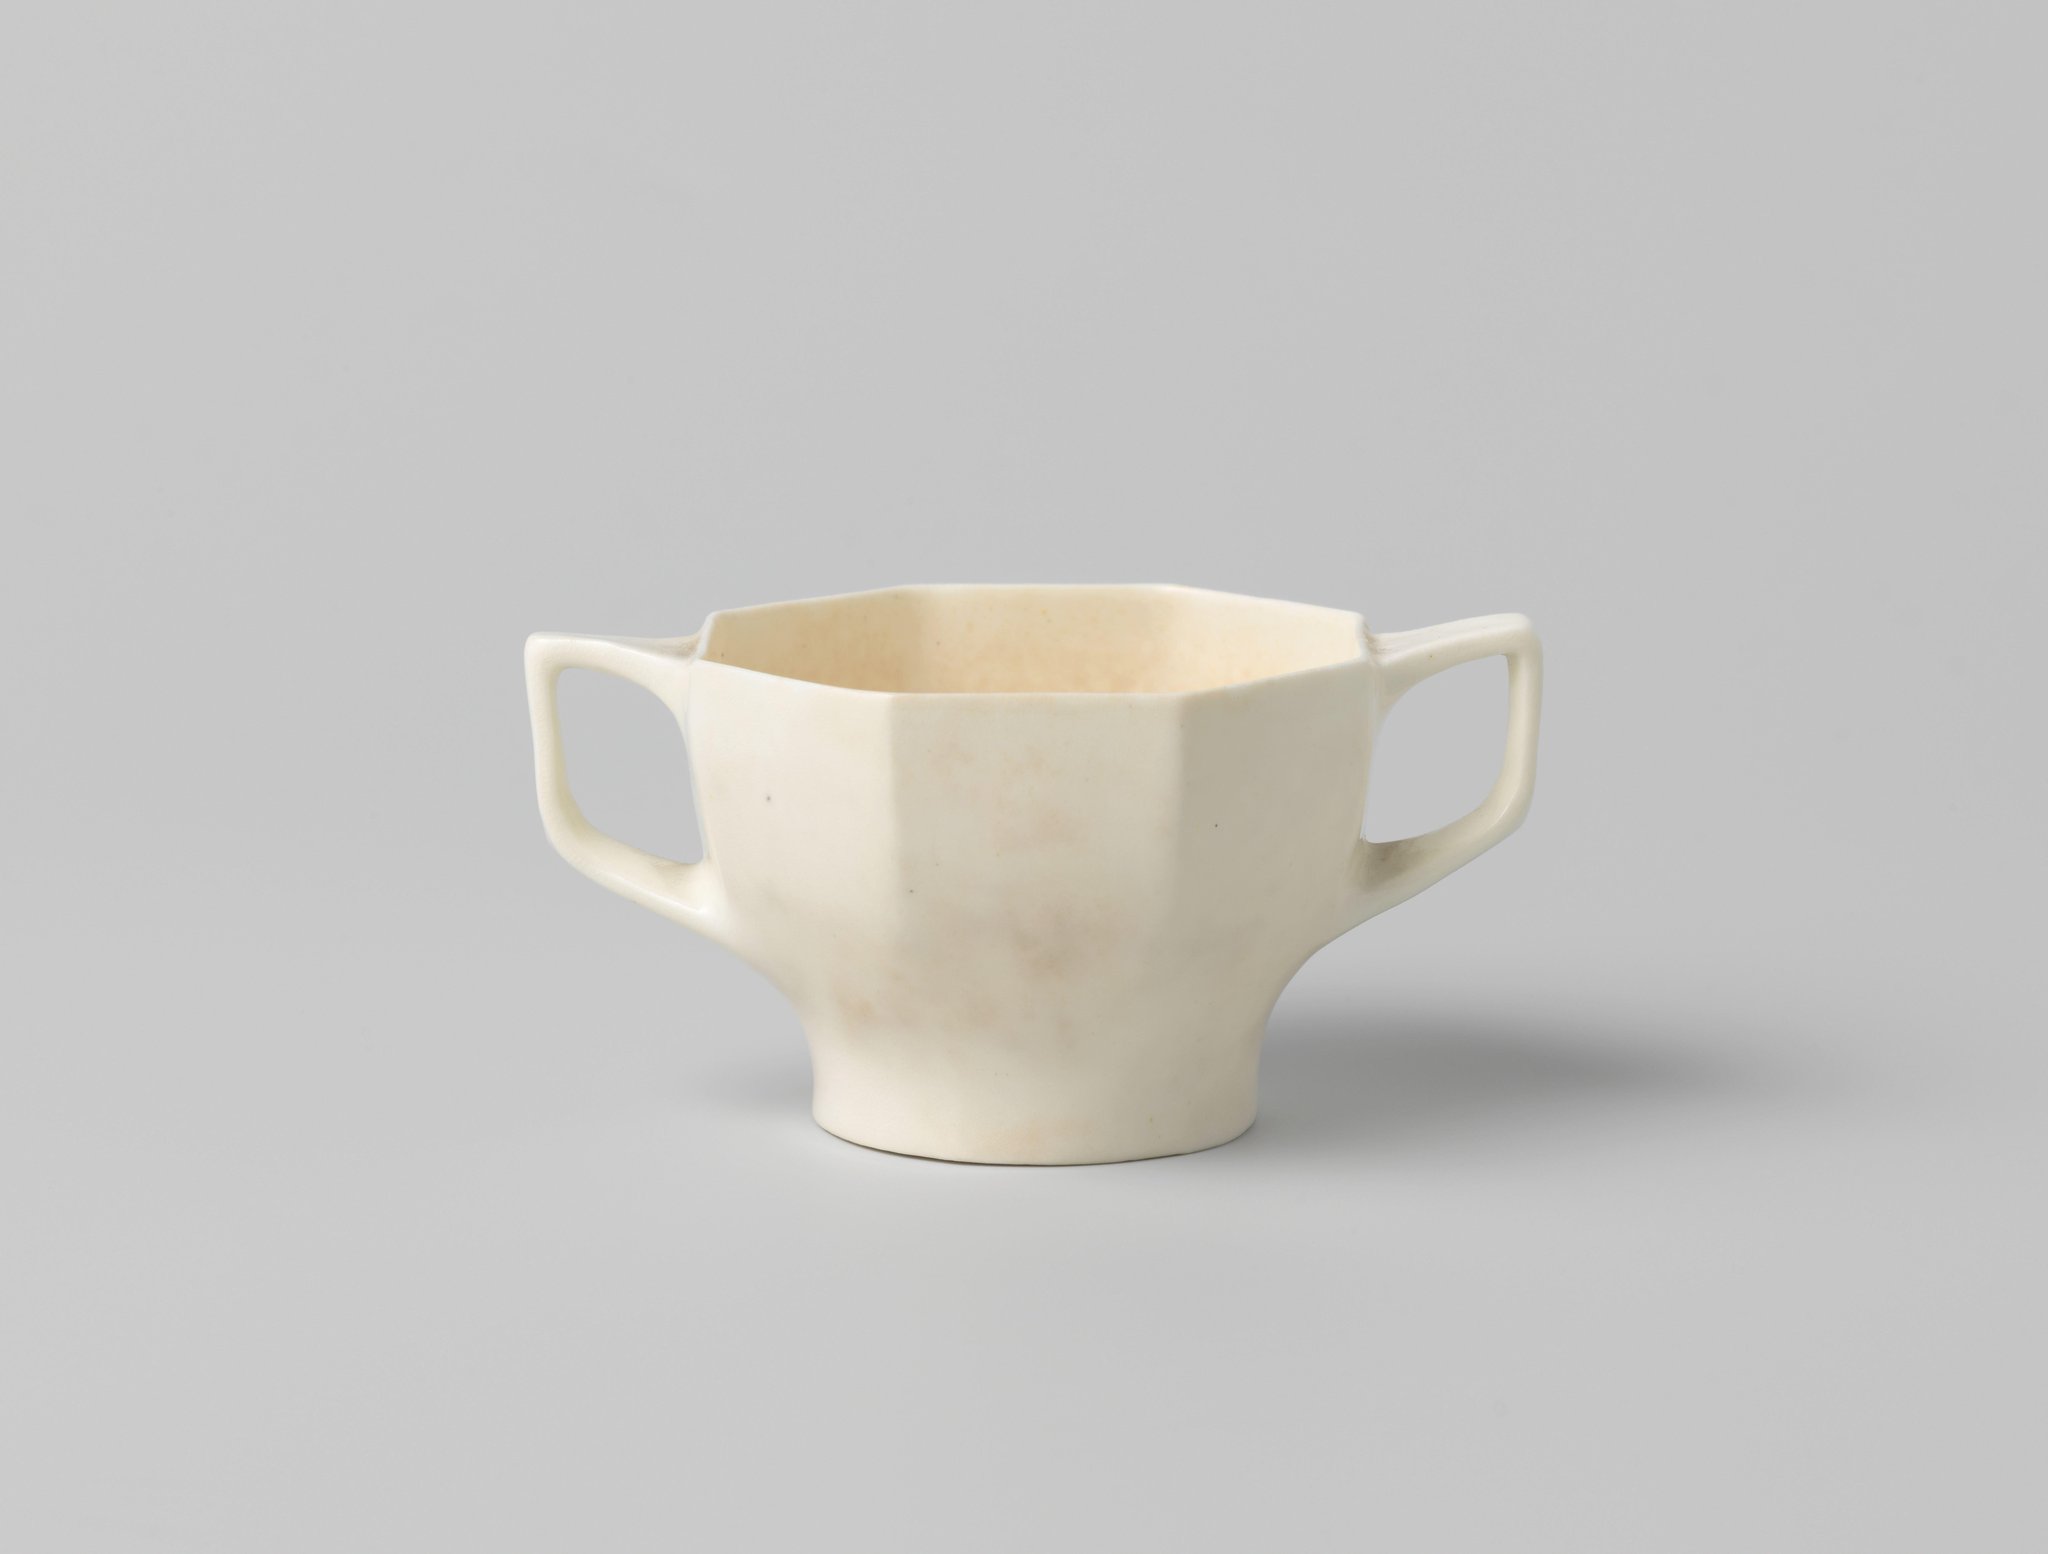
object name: cup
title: Kop, achthoekig, wit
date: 1900-2000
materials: porcelain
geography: the hague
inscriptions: mark: ‘kroon // Rozenburg // ooievaar // den Haag’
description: Kop van porselein, achthoekig van vorm, met twee oren. Niet beschilderd. Hierbij hoort een schotel (B).